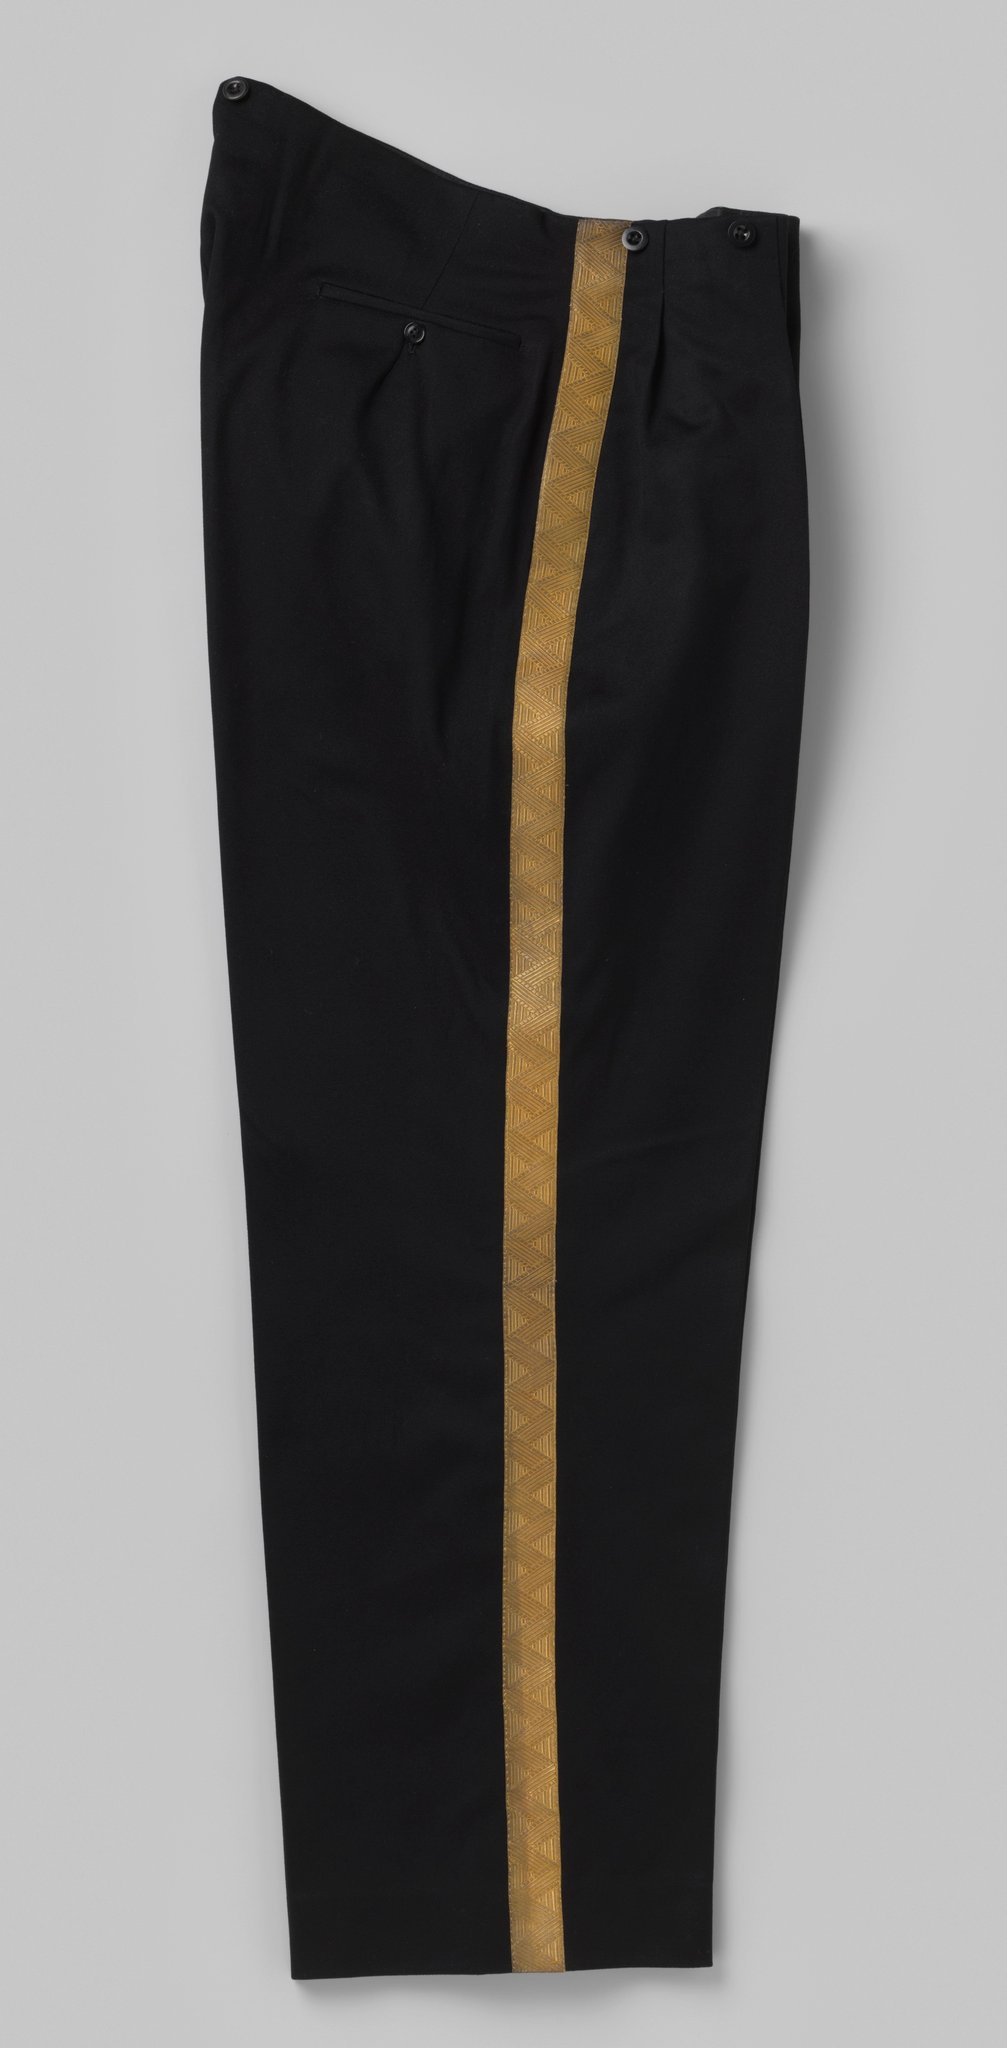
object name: pant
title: Broek van ambassadeur A.H.J. Lovink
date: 1948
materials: textile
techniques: embroidered, weave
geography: the hague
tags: the hague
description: Zwarte pantalon met goudband midden opzij op de pijpen gestikt, 2 achterzakken met knopen, 6 knopen voor bretels en 6 knopen voor de sluiting. Behorend bij ambtskostuum van ambassadeur A.H.J. Lovink.